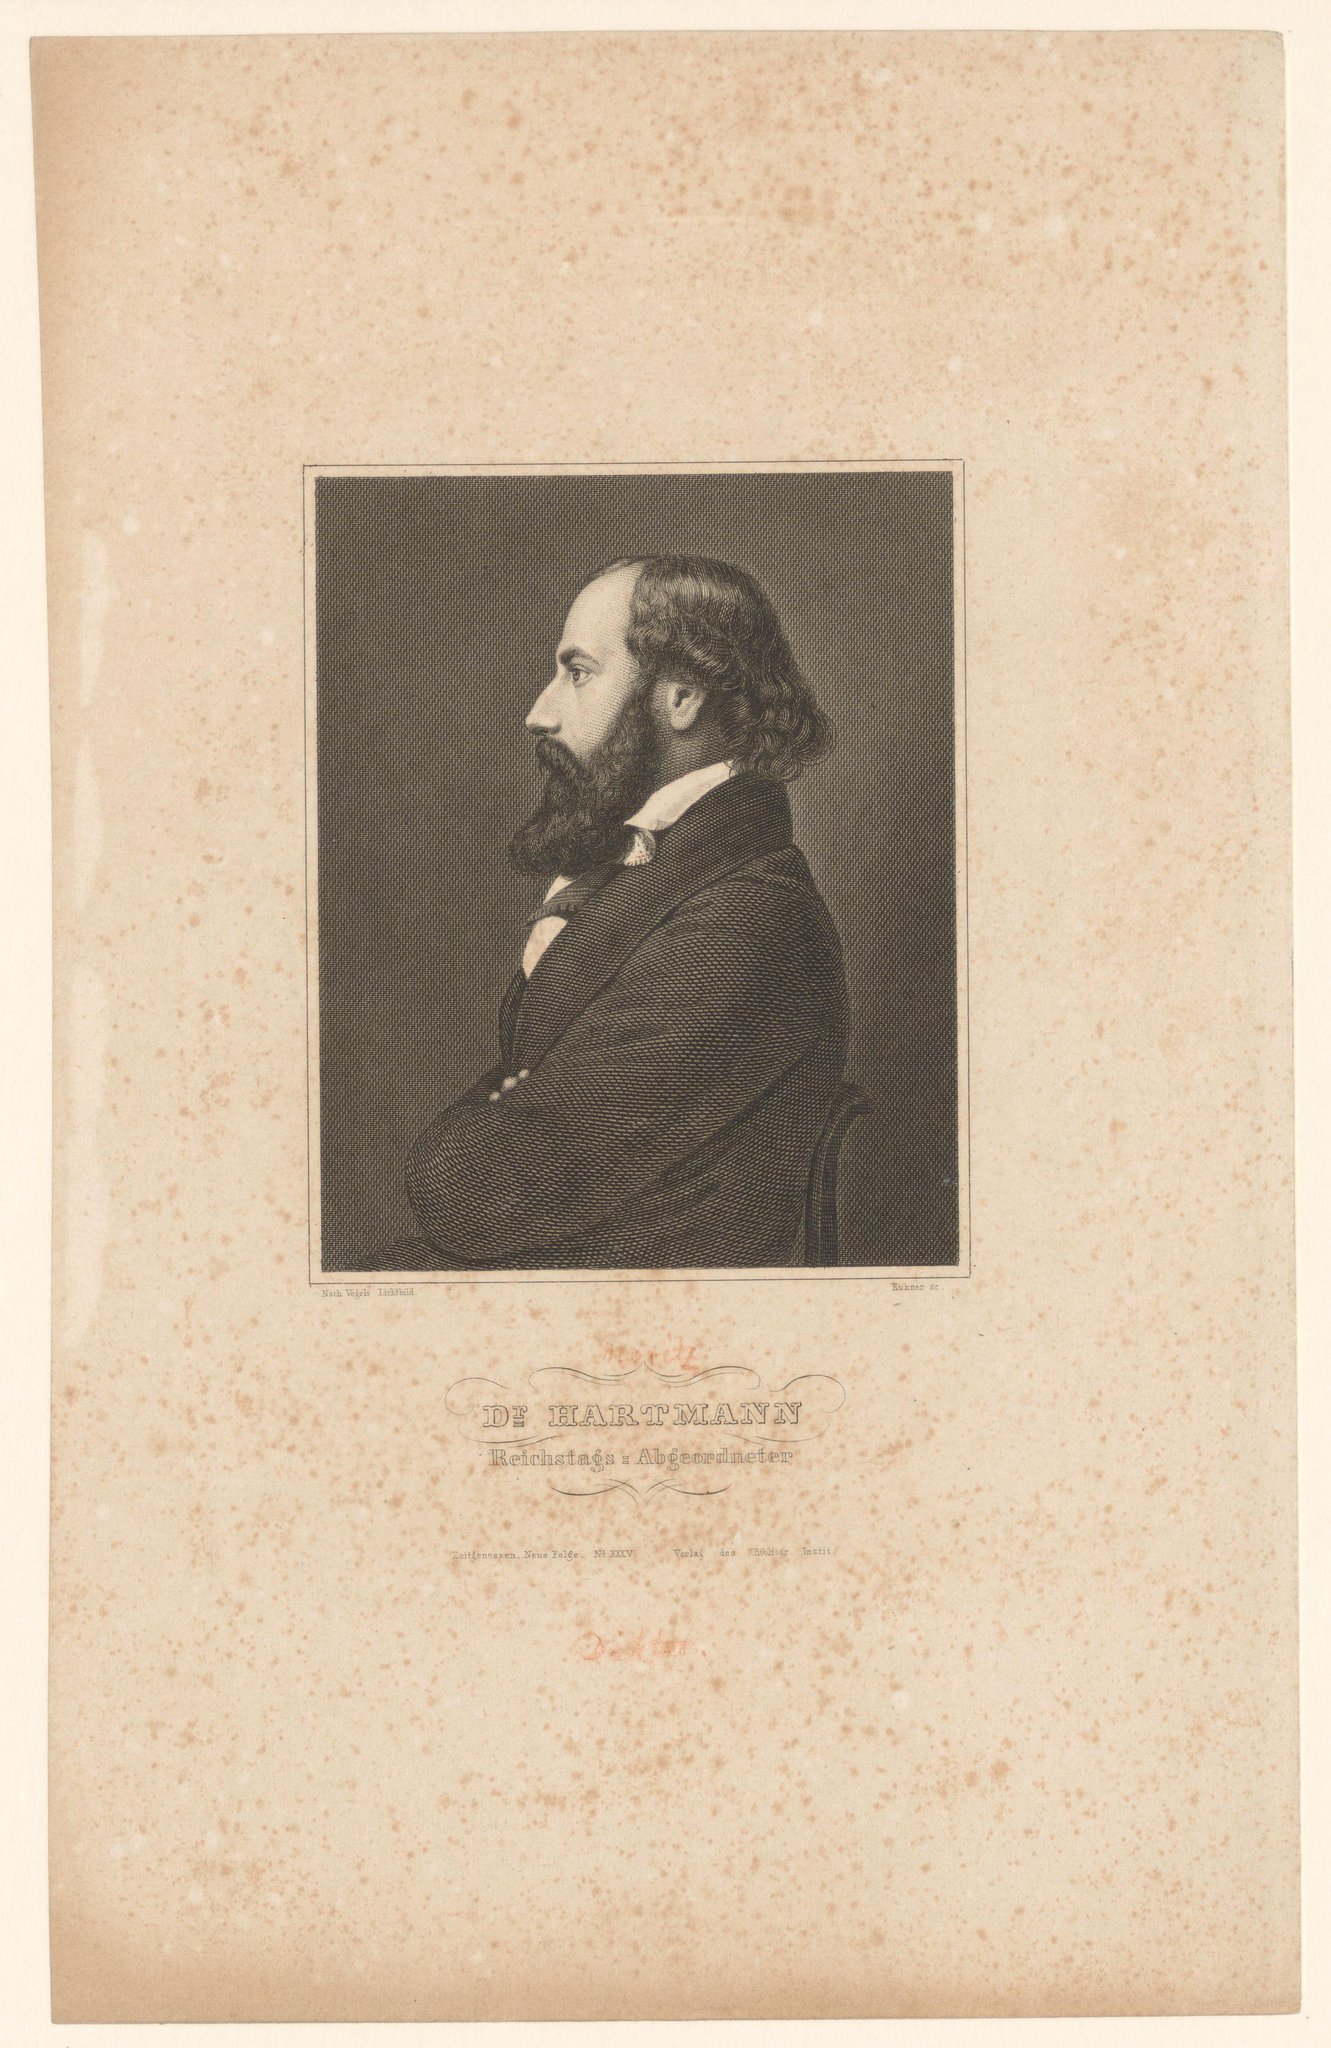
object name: print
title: Tijdgenoten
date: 1840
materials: paper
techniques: engraving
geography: hildburghausen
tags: publishing, publisher (+ portrait of scholar, scientist), historical persons, portrait of a writer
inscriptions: collector's mark: Lugt 2228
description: Afkomstig uit de portretserie 'Zeitgenossen' nr. 35, uitgegeven na 1840.